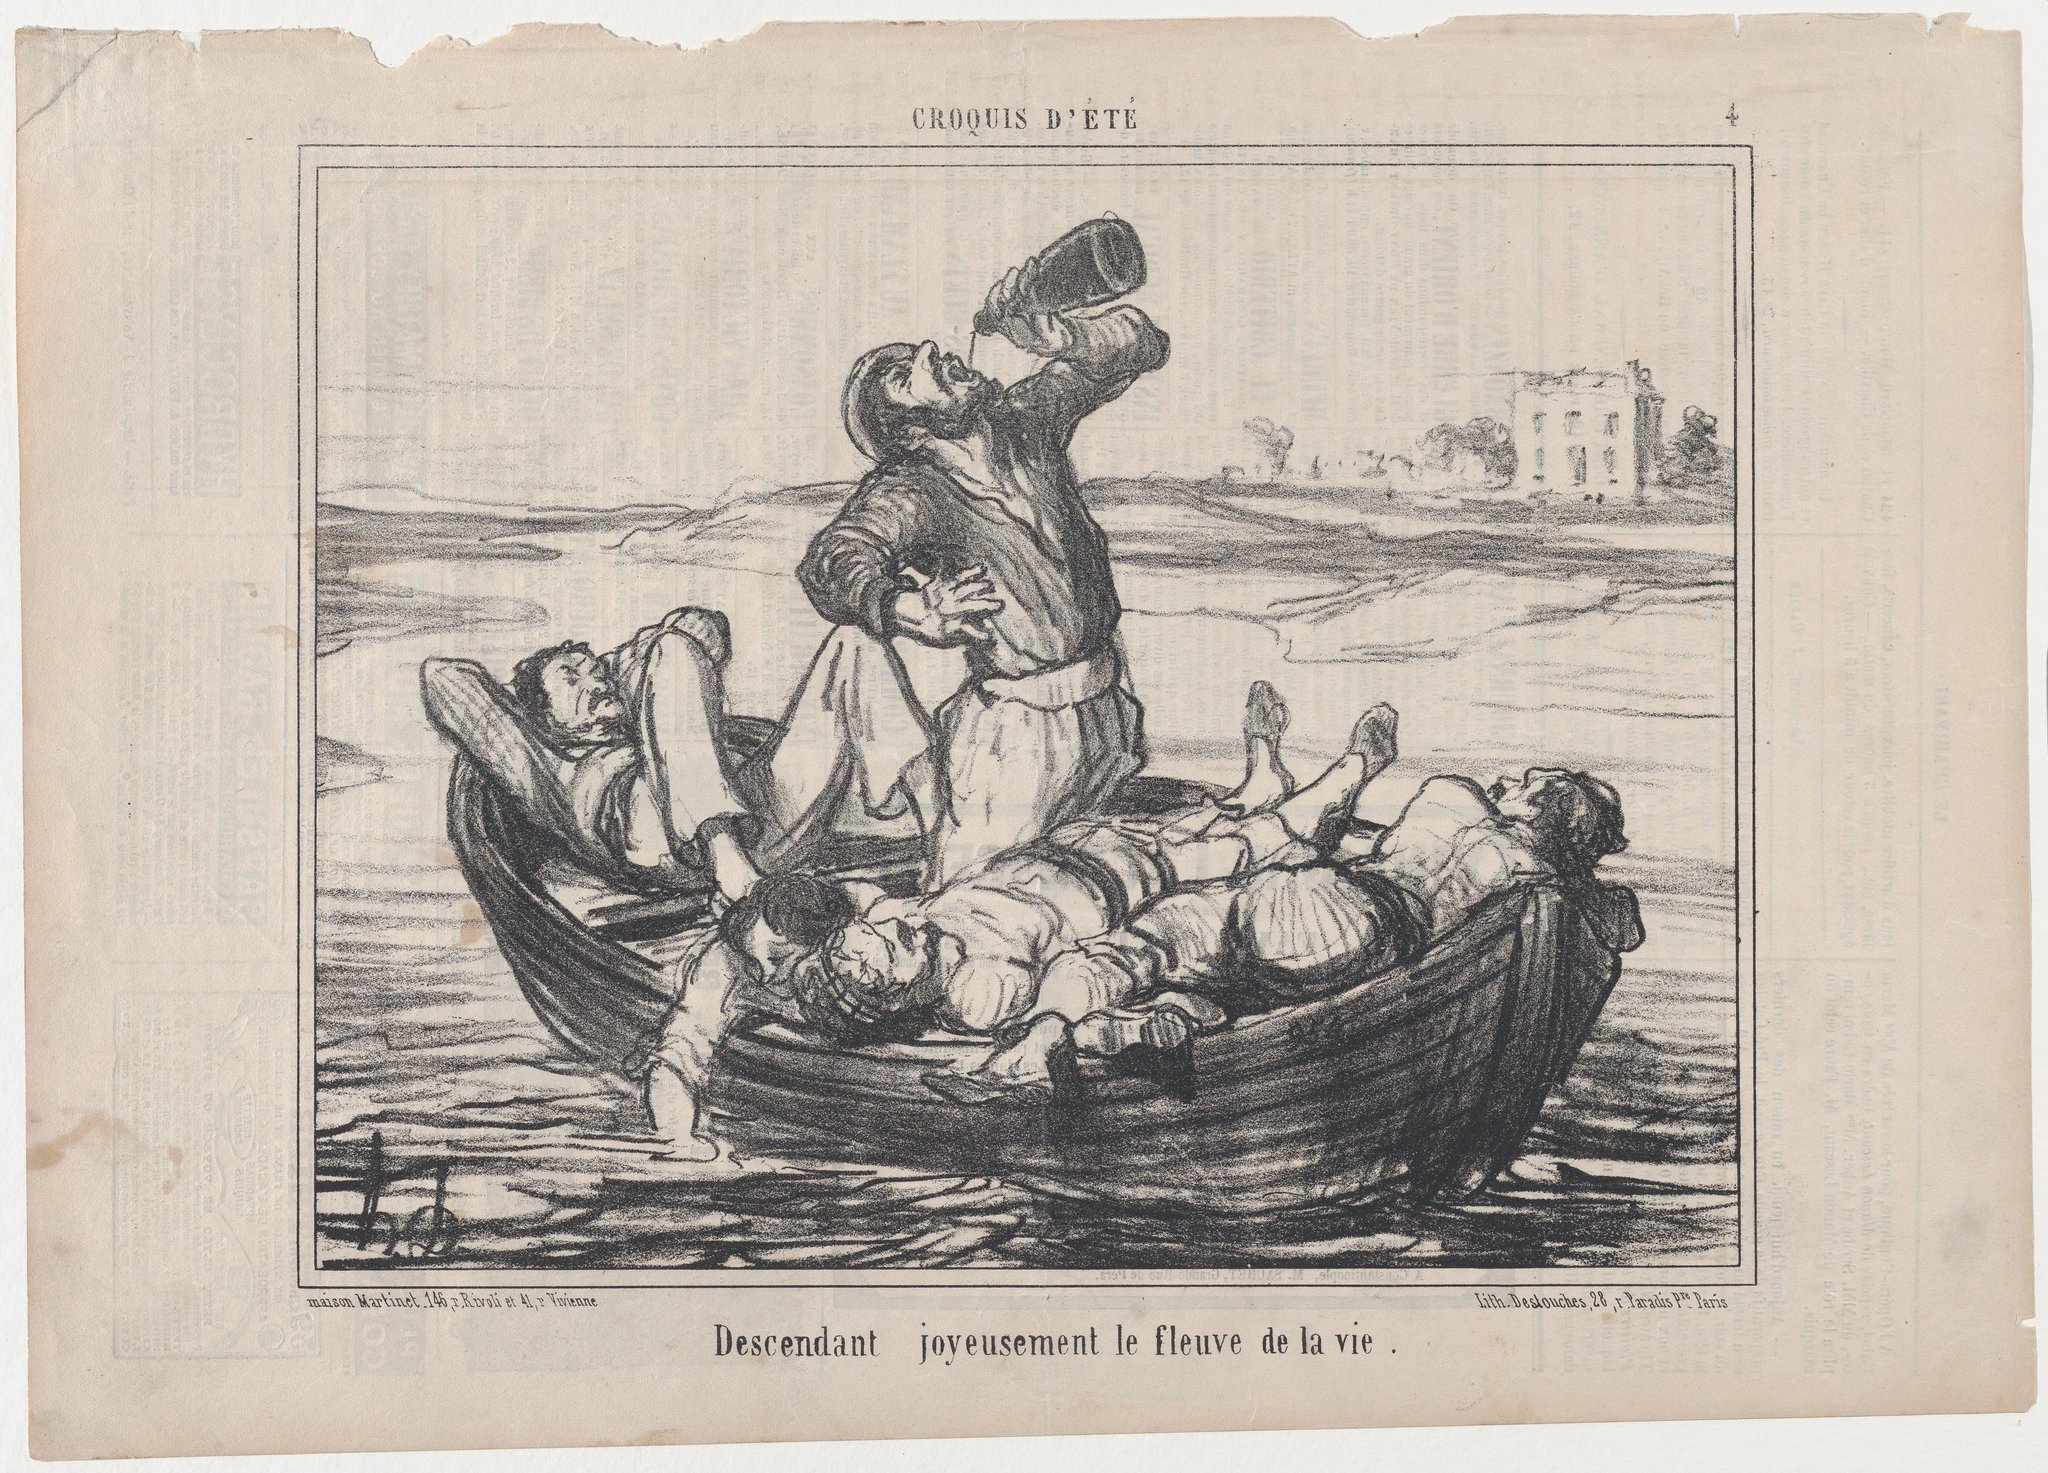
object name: print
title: Descendant joyeuseument le fleuve de la vie, from "Croquis d'Été"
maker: honoré daumier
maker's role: artist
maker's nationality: french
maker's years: 1808-1879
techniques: lithograph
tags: satire,drunkenness,men,summer,boats